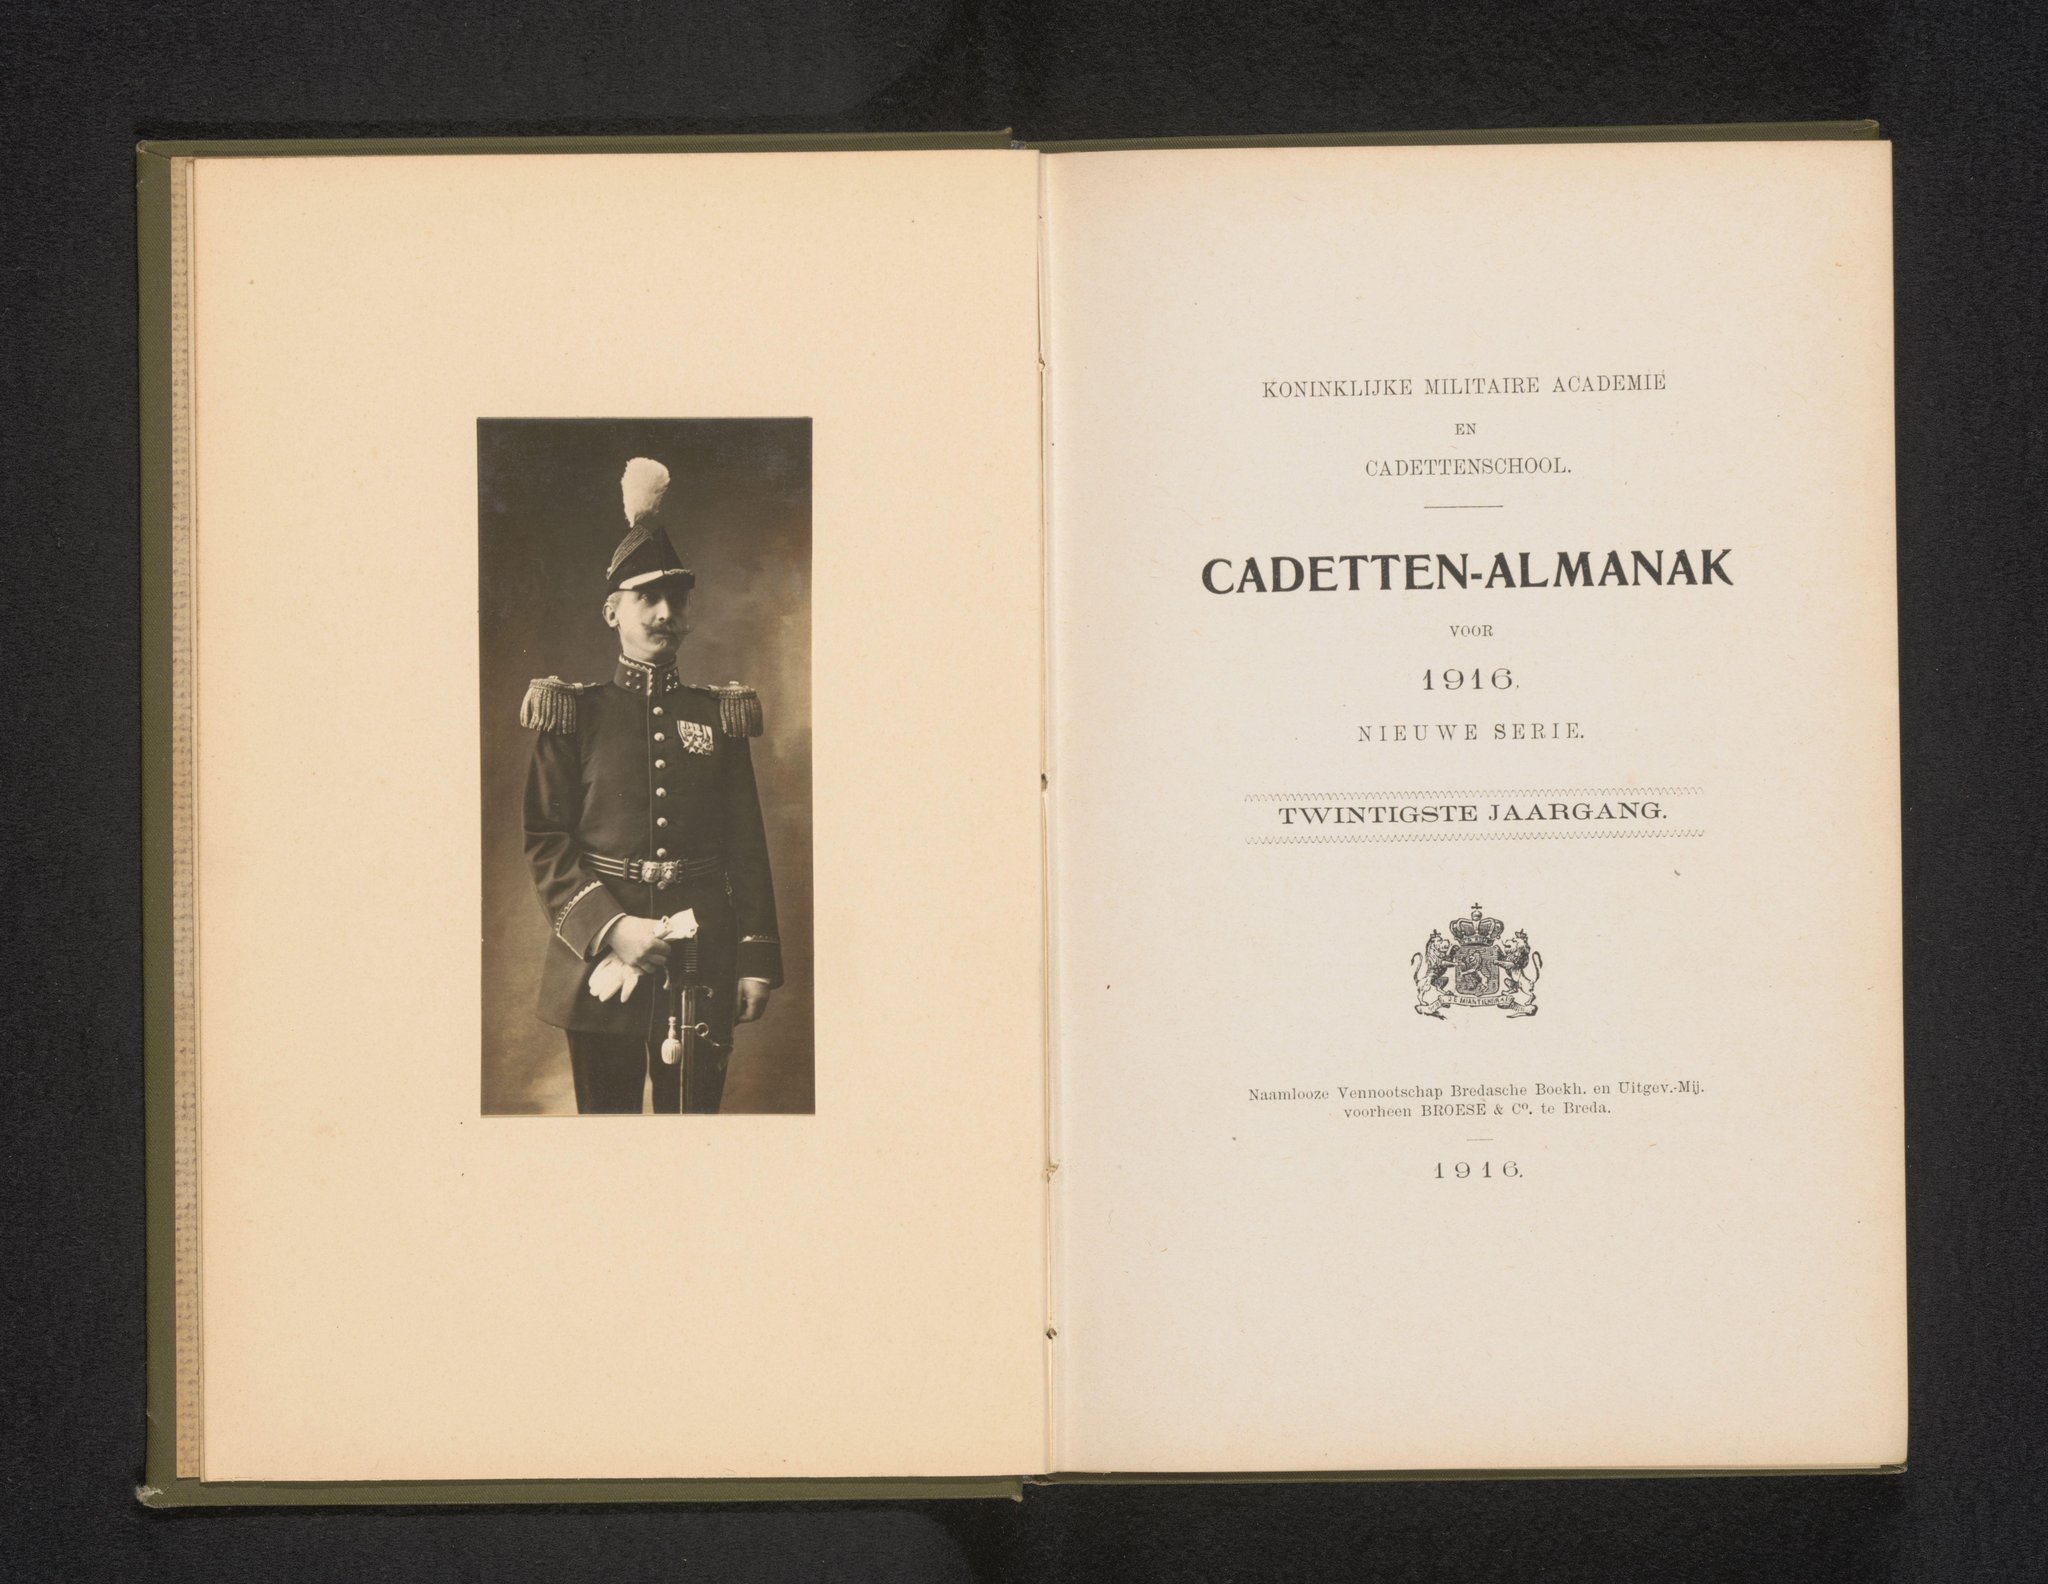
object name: page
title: Portret van een onbekende hooggeplaatste militair aan de Koninklijke Militaire Academie in Breda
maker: Anonymous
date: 1911-1916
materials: photographic support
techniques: gelatin silver print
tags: officer, historical persons not known by name